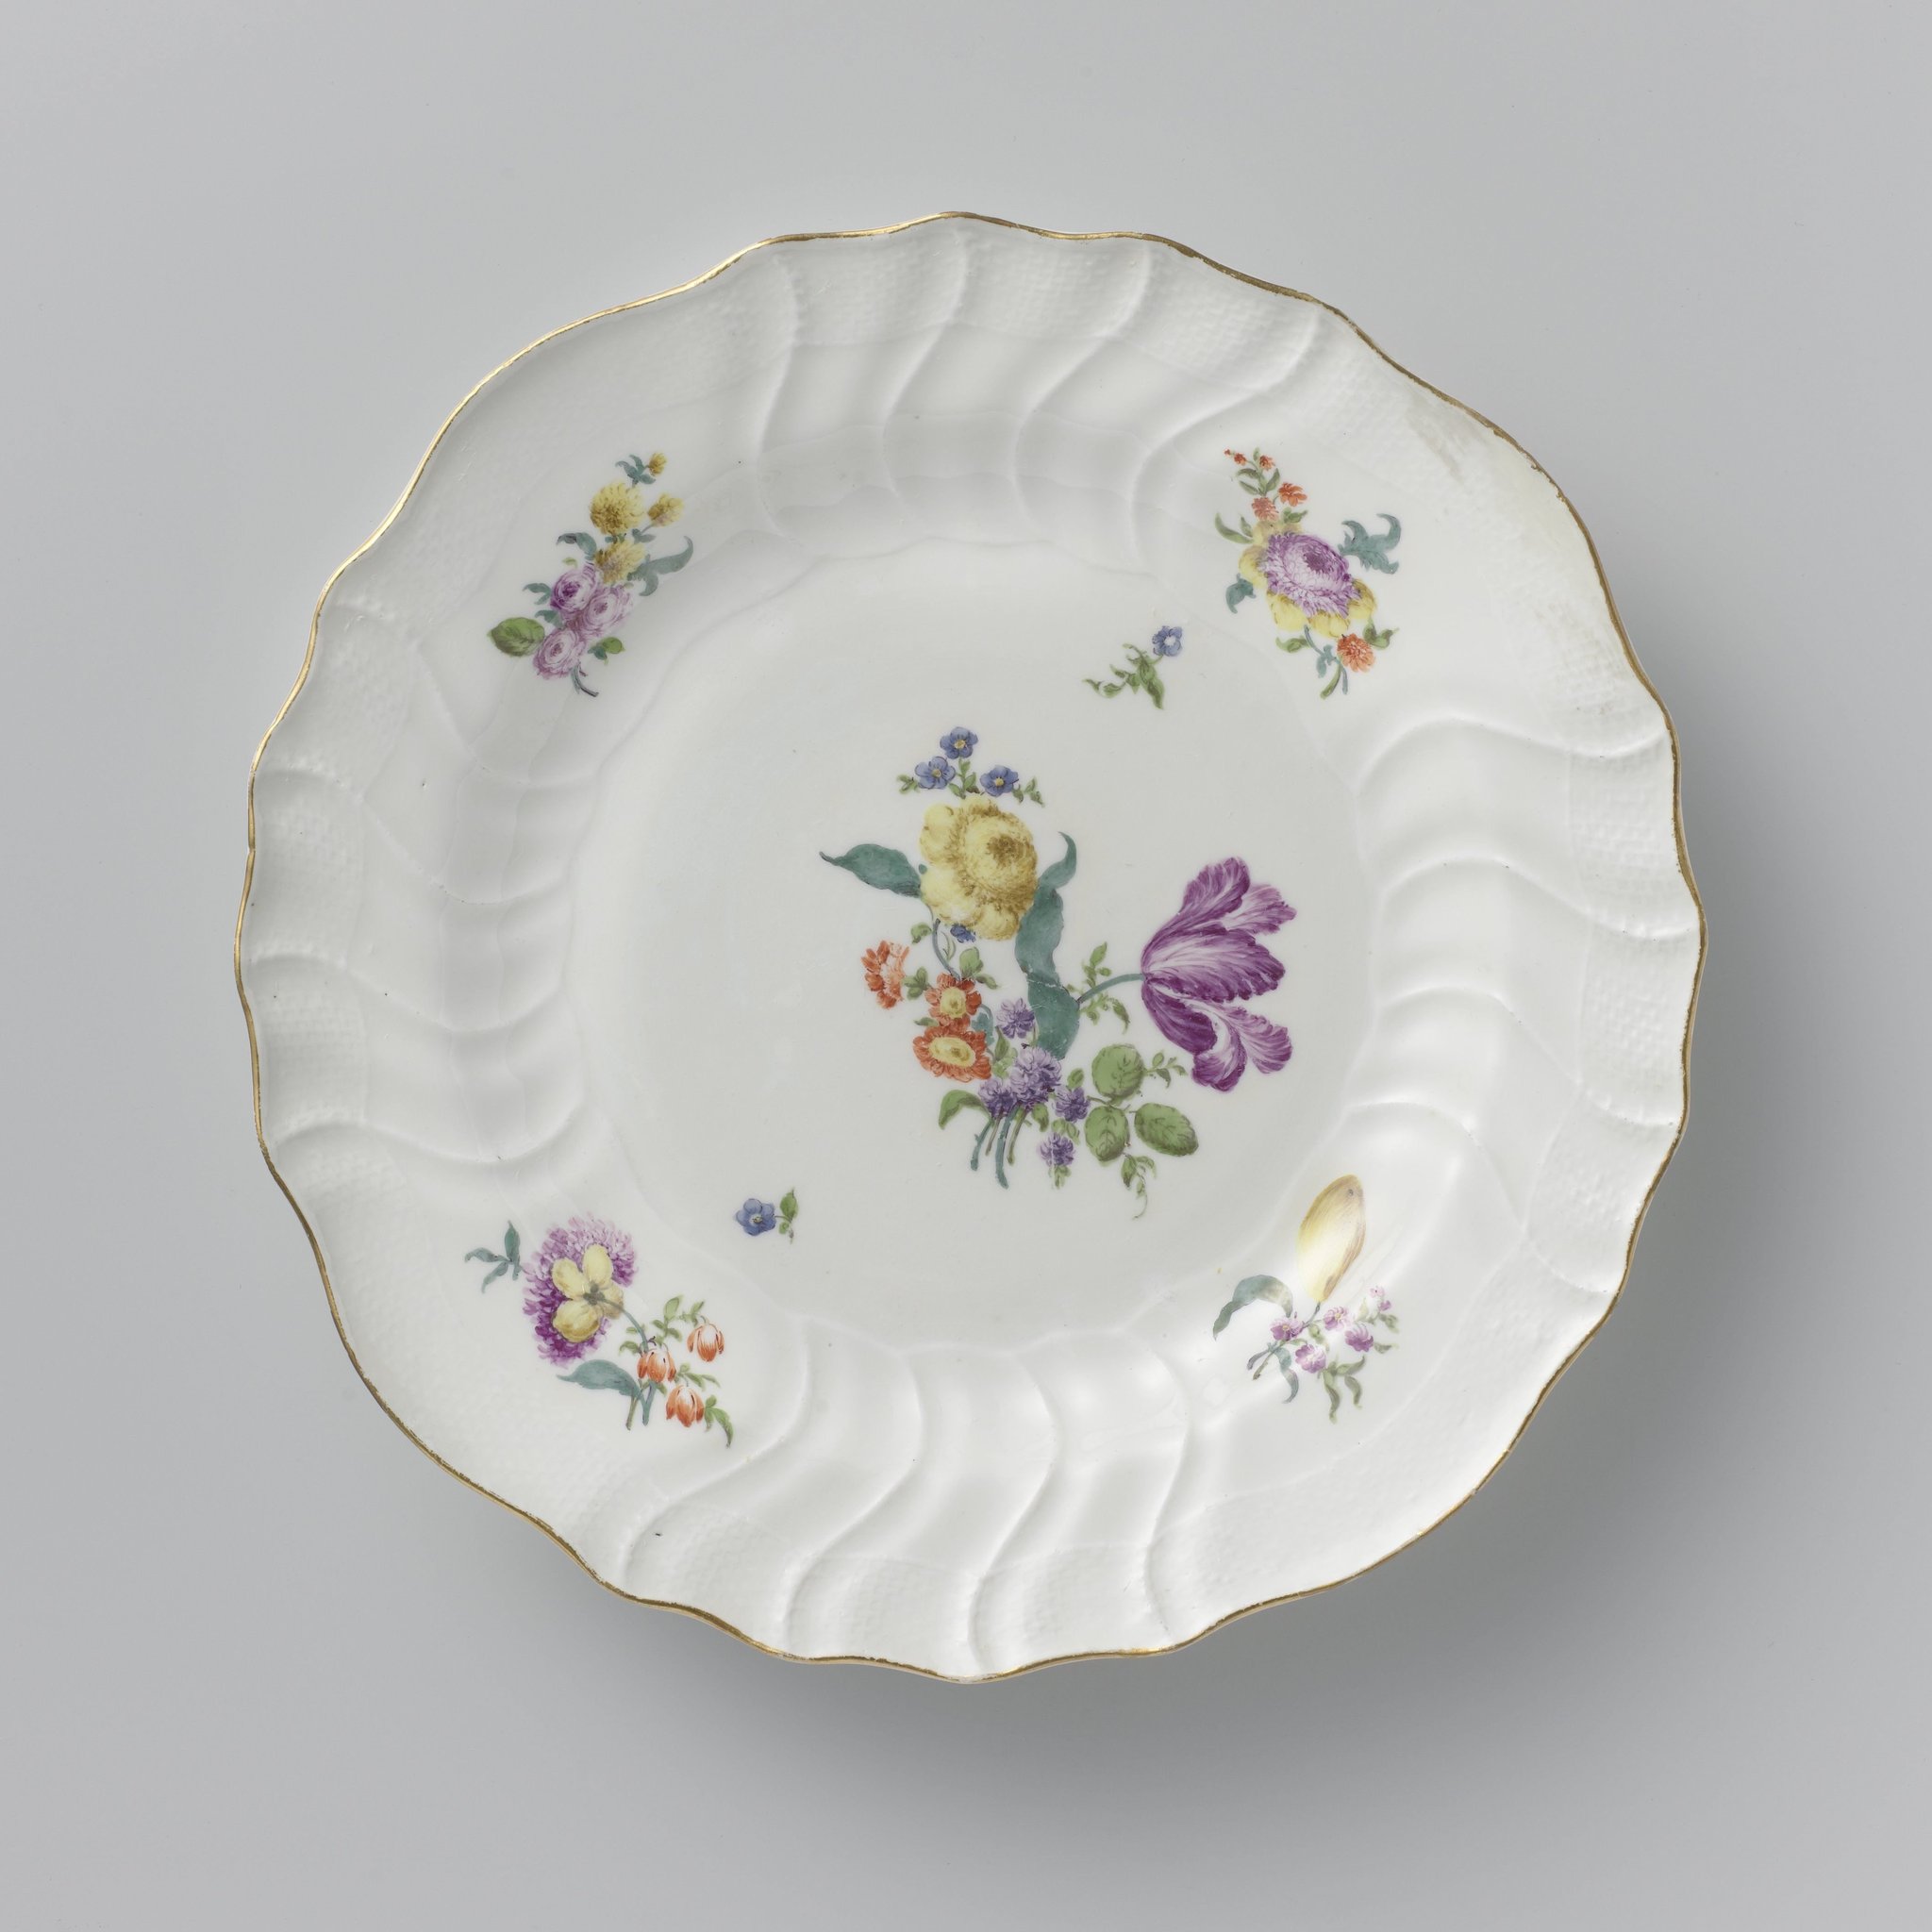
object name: eating drinking utensil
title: Bord, veelkleurig beschilderd met Deutsche Blumen, insekten en vruchten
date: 1750-1760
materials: porcelain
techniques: painted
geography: meissen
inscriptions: factory mark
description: Rond bord van beschilderd porselein. Het bord is beschilderd met Deutsche Blumen, insekten en vruchten. De rand is in reliëf versierd met het Neuozier-patroon. Het bord is gemerkt en hoort bij een servies (BK-17474-1 t/m BK-17474-253).